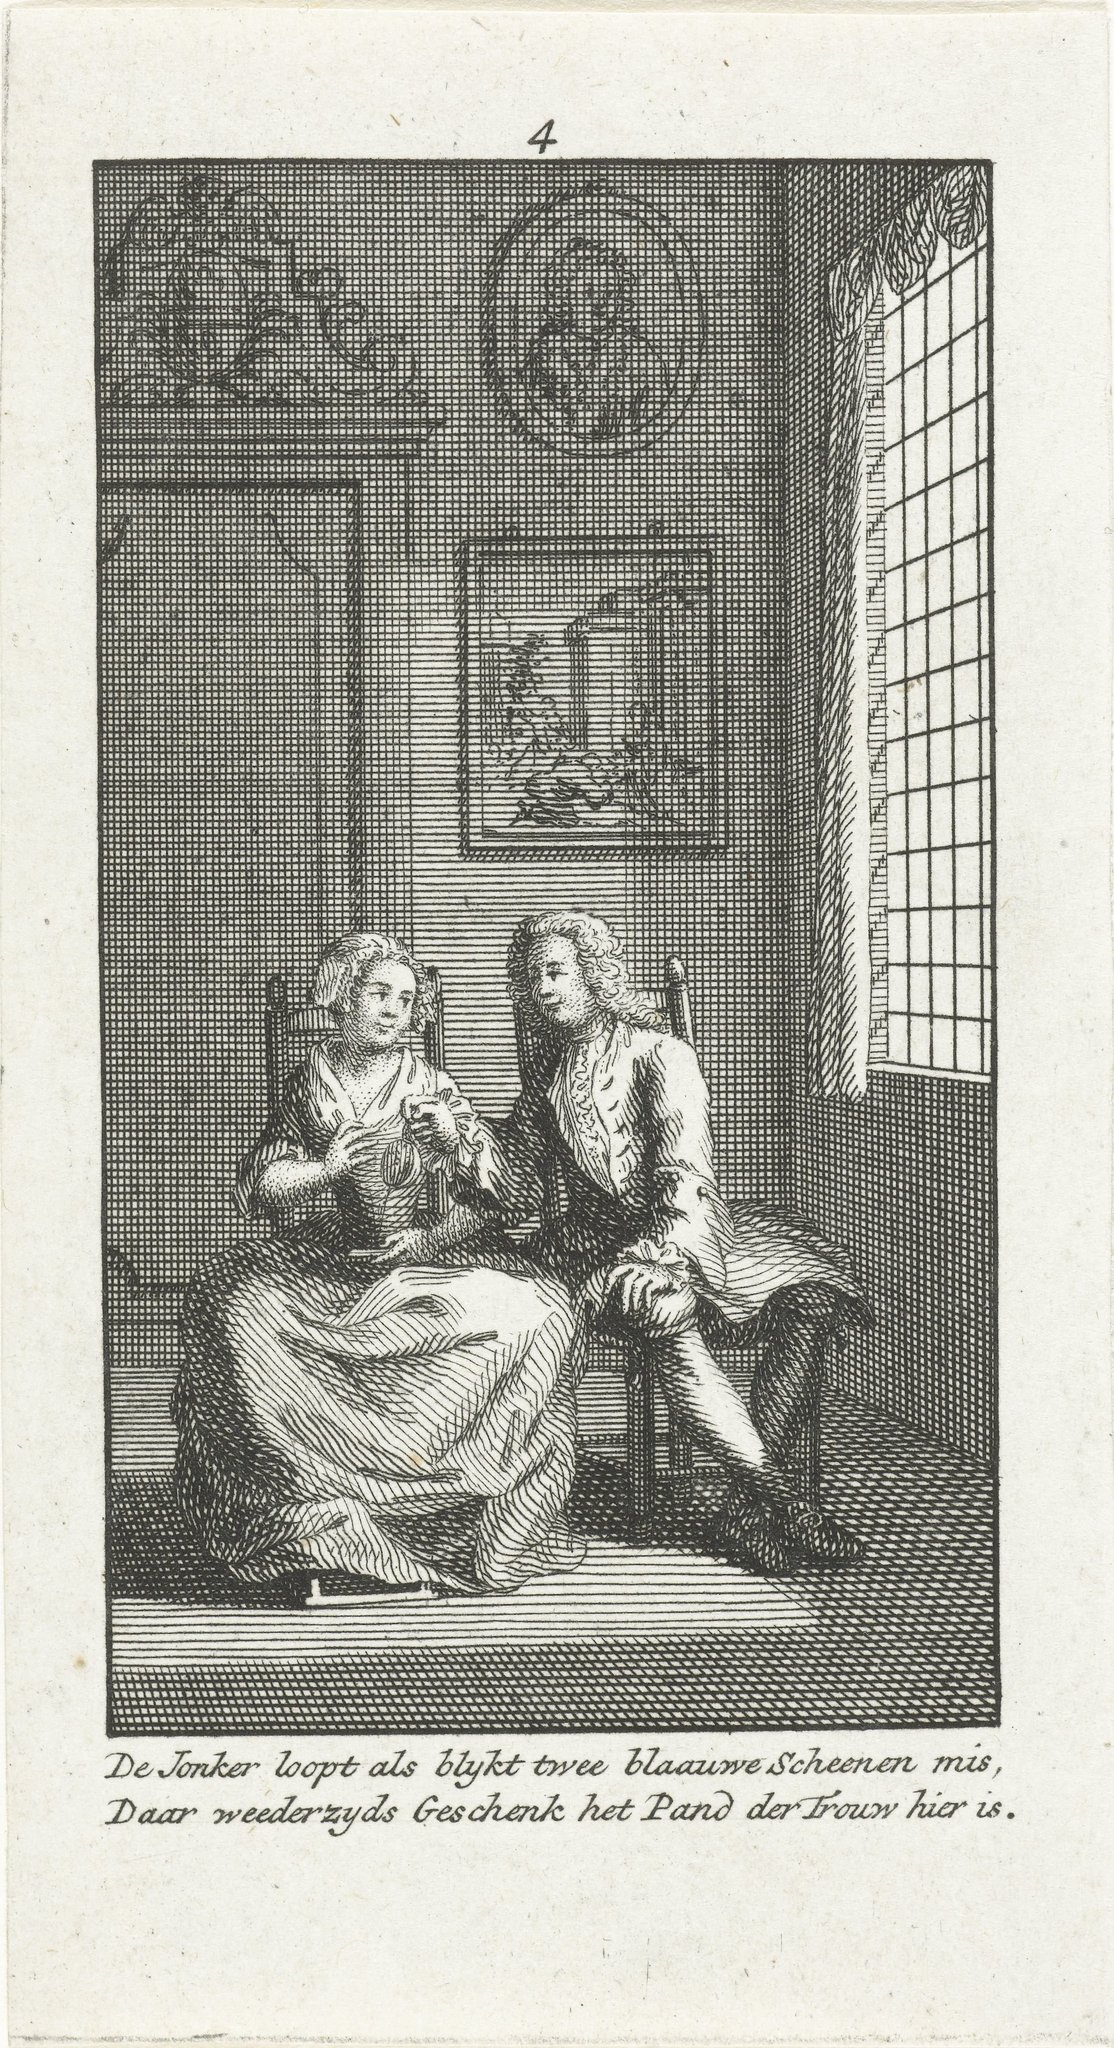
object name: print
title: Het Vrijen, Trouwen en eerste Kraambed in eene deftige Hollandsche huishouding omstreeks 1750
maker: jan caspar philips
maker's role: draughtsman, print maker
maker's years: 1700-1775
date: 1740-1760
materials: paper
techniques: engraving, etching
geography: northern netherlands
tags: courting, bringing gifts; exchanging gifts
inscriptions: collector's mark: Lugt 2228, caption: ‘De Jonker loopt ... Trouw hier is..’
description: Interieur met man en vrouw naast elkaar op stoel, waarbij hij een geschenk op haar schoot legt. Prent nr. 4 in een serie van twaalf prentjes met tweeregelige versjes over de Hollandse gewoontes bij het huwelijk ca. 1750.